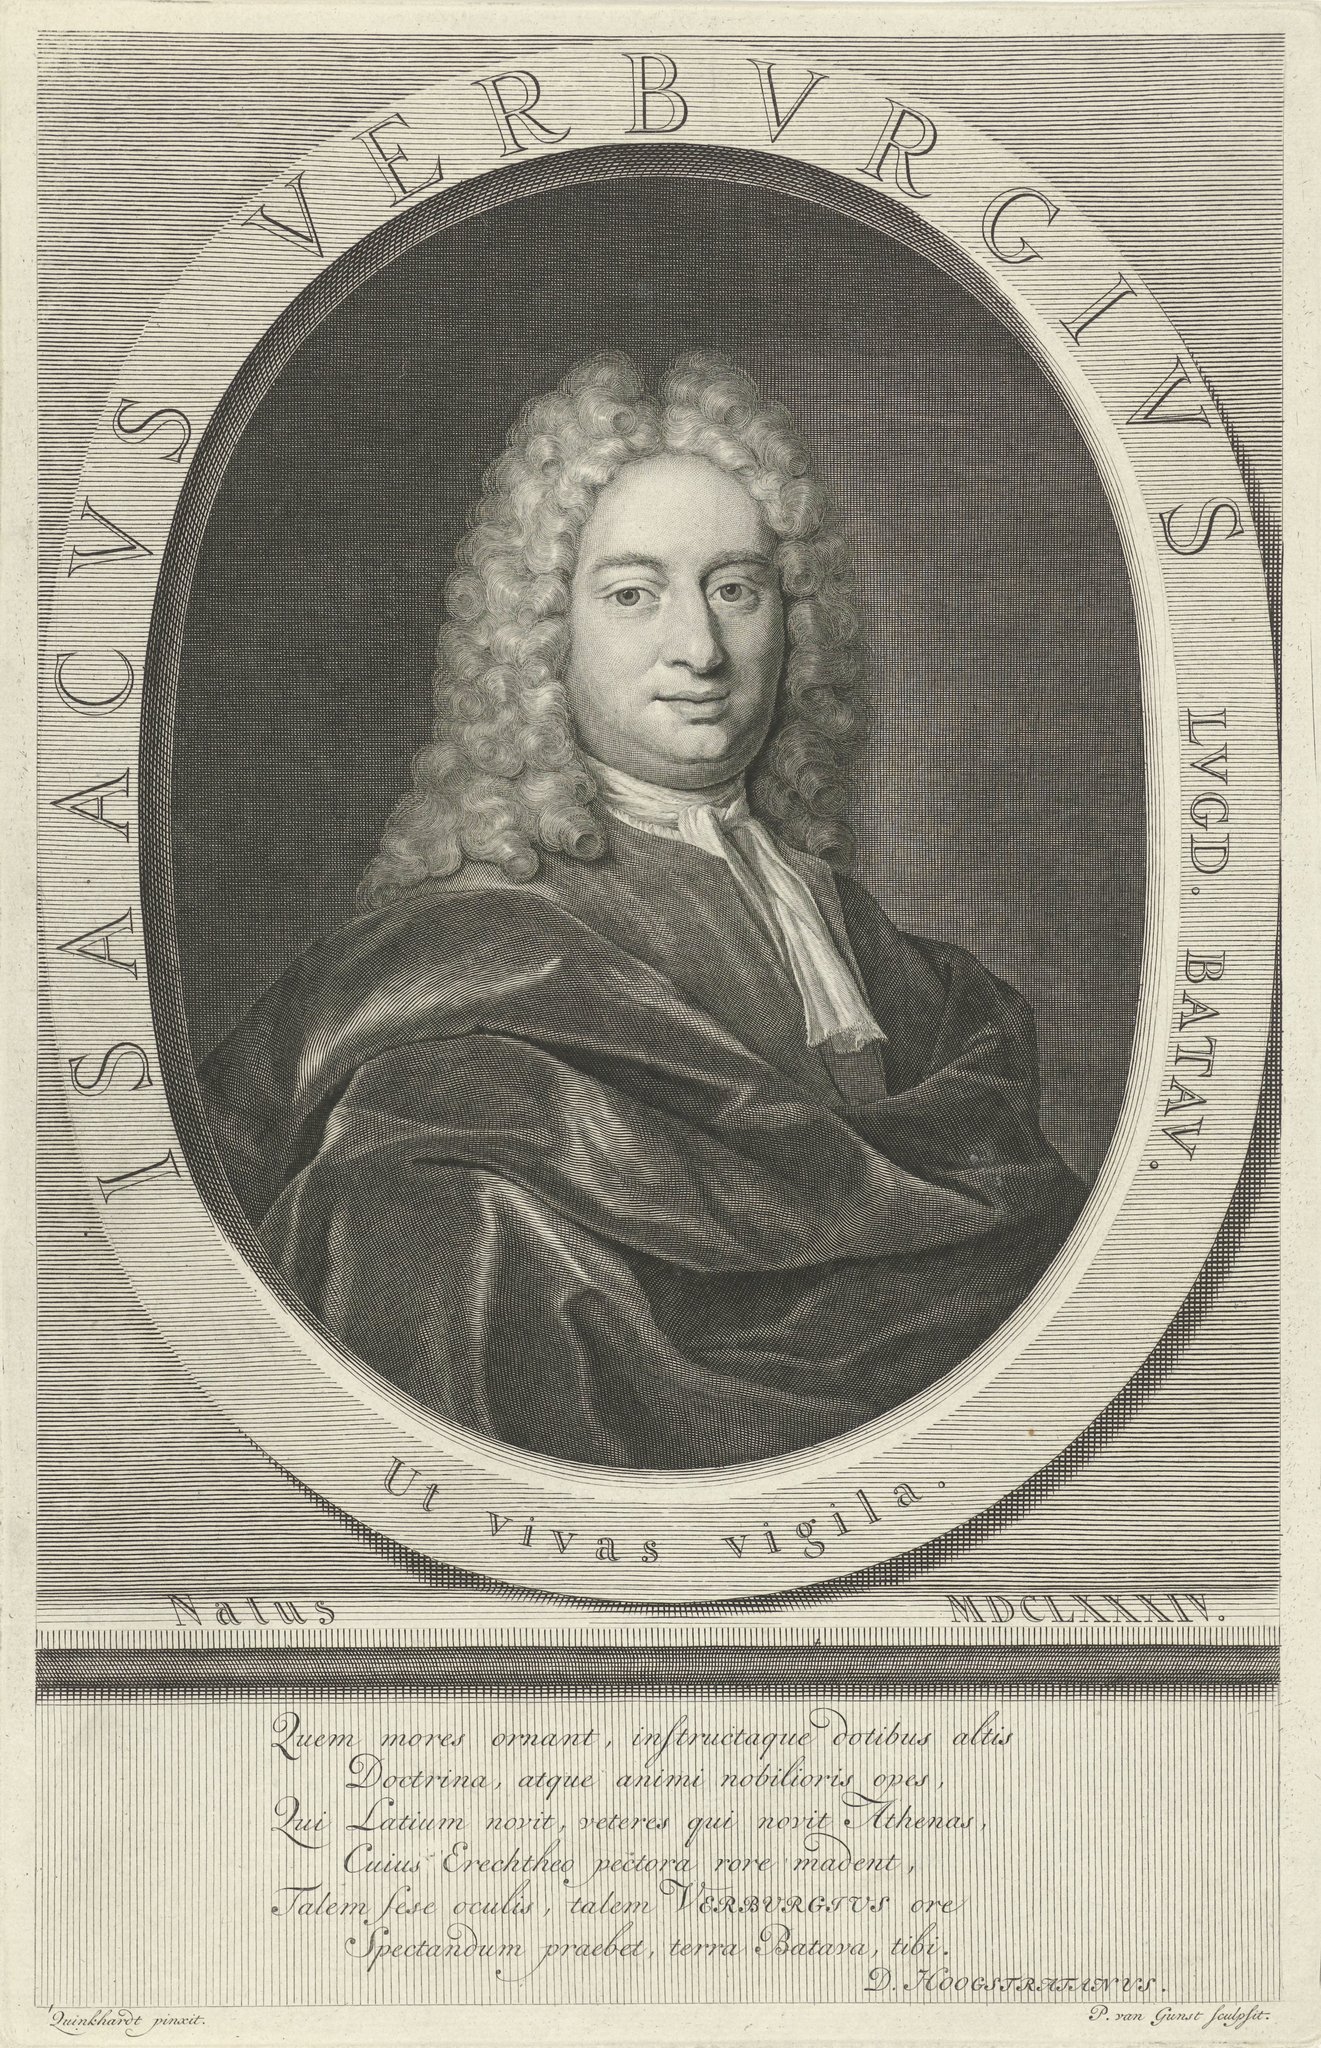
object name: print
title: Portret van Isaac Verburg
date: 1704-1731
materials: paper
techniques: engraving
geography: amsterdam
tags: leiden, isaac verburg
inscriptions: collector's mark: Lugt 2228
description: Isaac Verburg, rector der Latijnse scholen te Amsterdam, professor klassieke talen en historieschrijver te Leiden. De prent heeft een Latijns onderschrift.